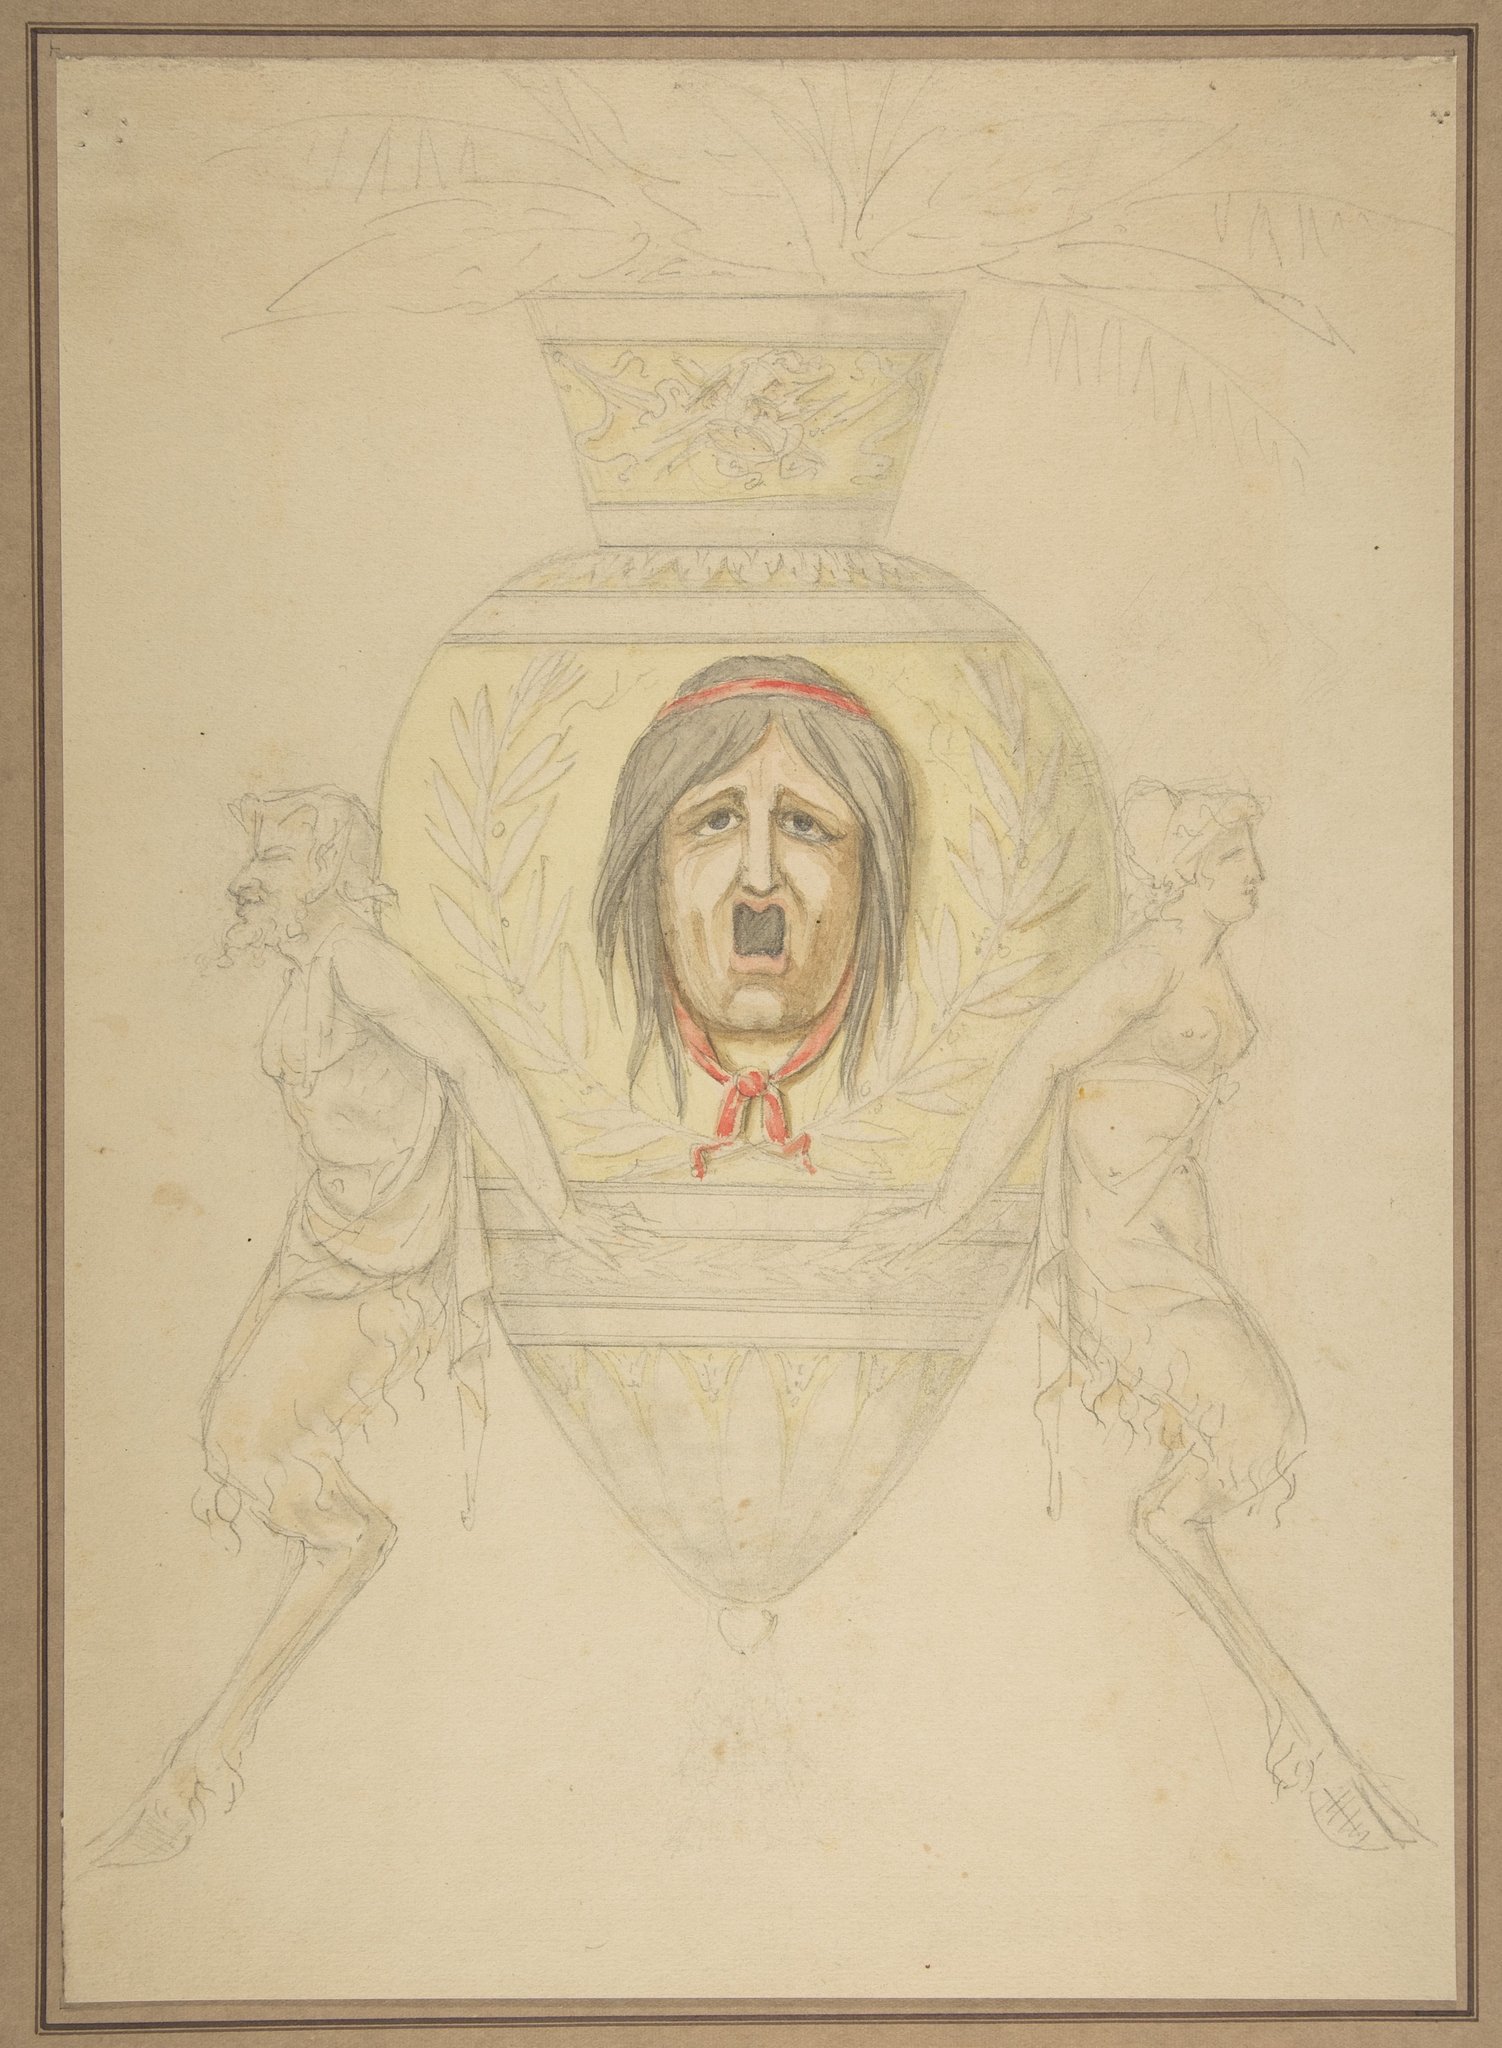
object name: drawing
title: Design for a vase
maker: anonymous, french, 19th century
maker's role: artist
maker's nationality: french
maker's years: 1800-1900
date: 1801-1900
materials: graphite, watercolor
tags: faces,vases